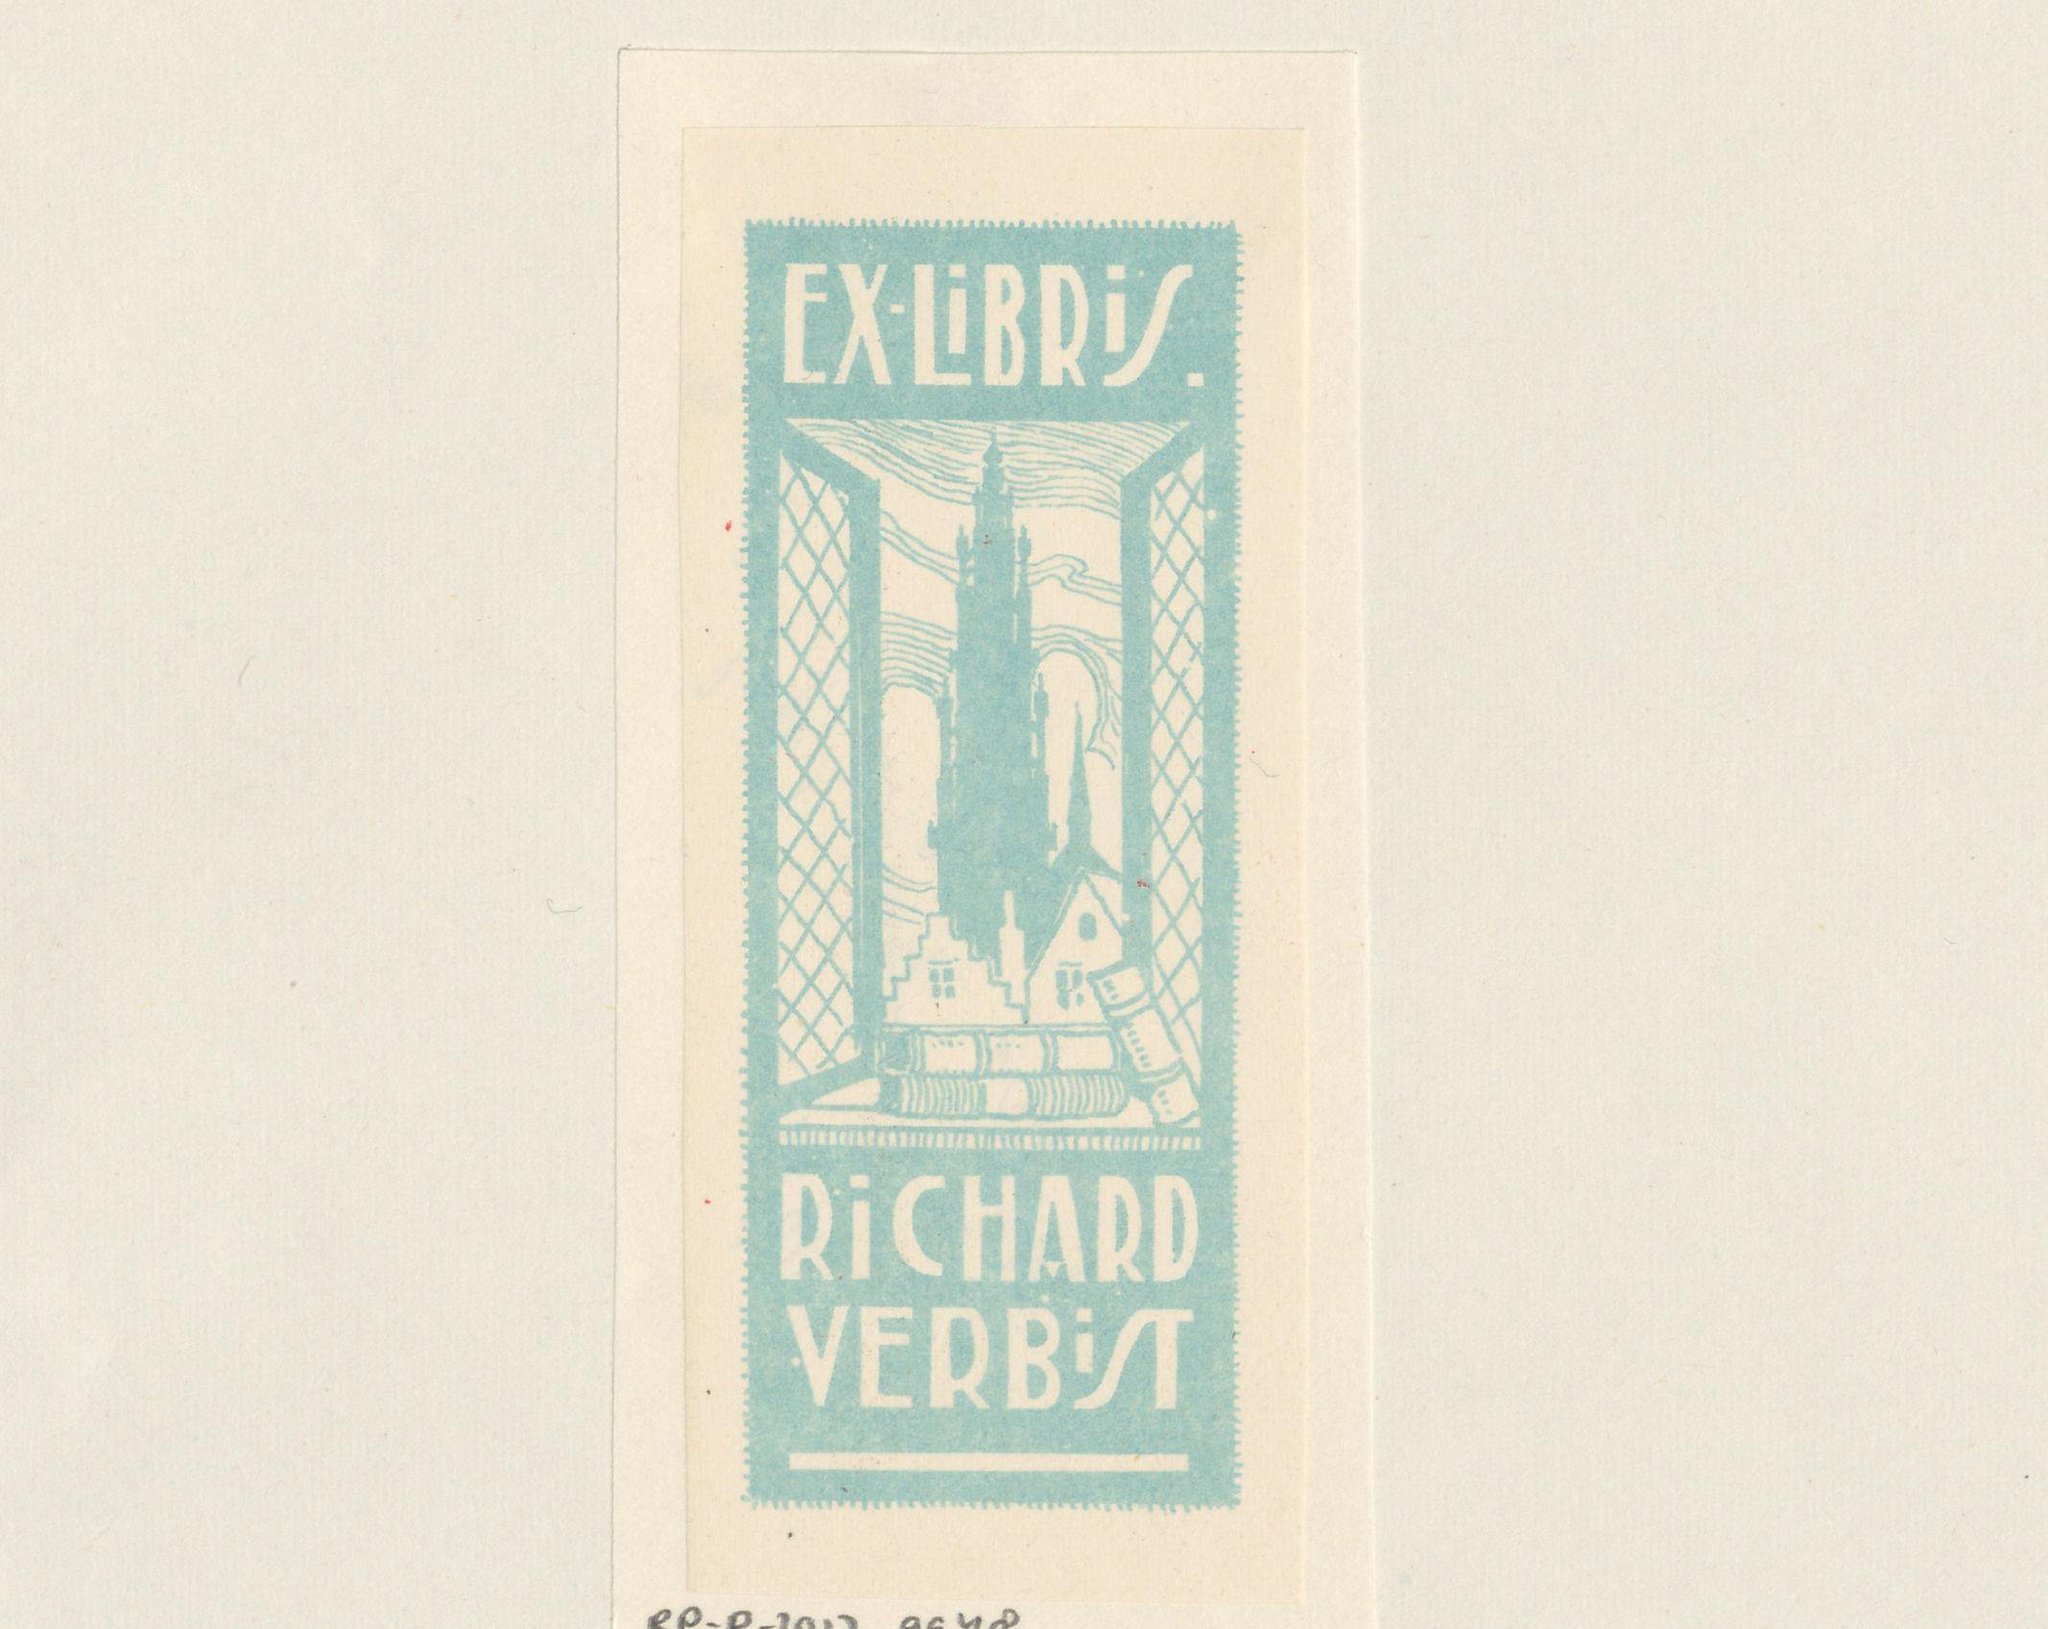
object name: bookplate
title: Ex libris van Richard Verbist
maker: willem seyters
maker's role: print maker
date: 1926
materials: paper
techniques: lithograph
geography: antwerp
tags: parts of church exterior and annexes: campanile, view through a window, book, prospect of city, town panorama, silhouette of city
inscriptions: inscription: ‘Willem Sey[...]/ Antwerpen/ 1926 Lithographie’